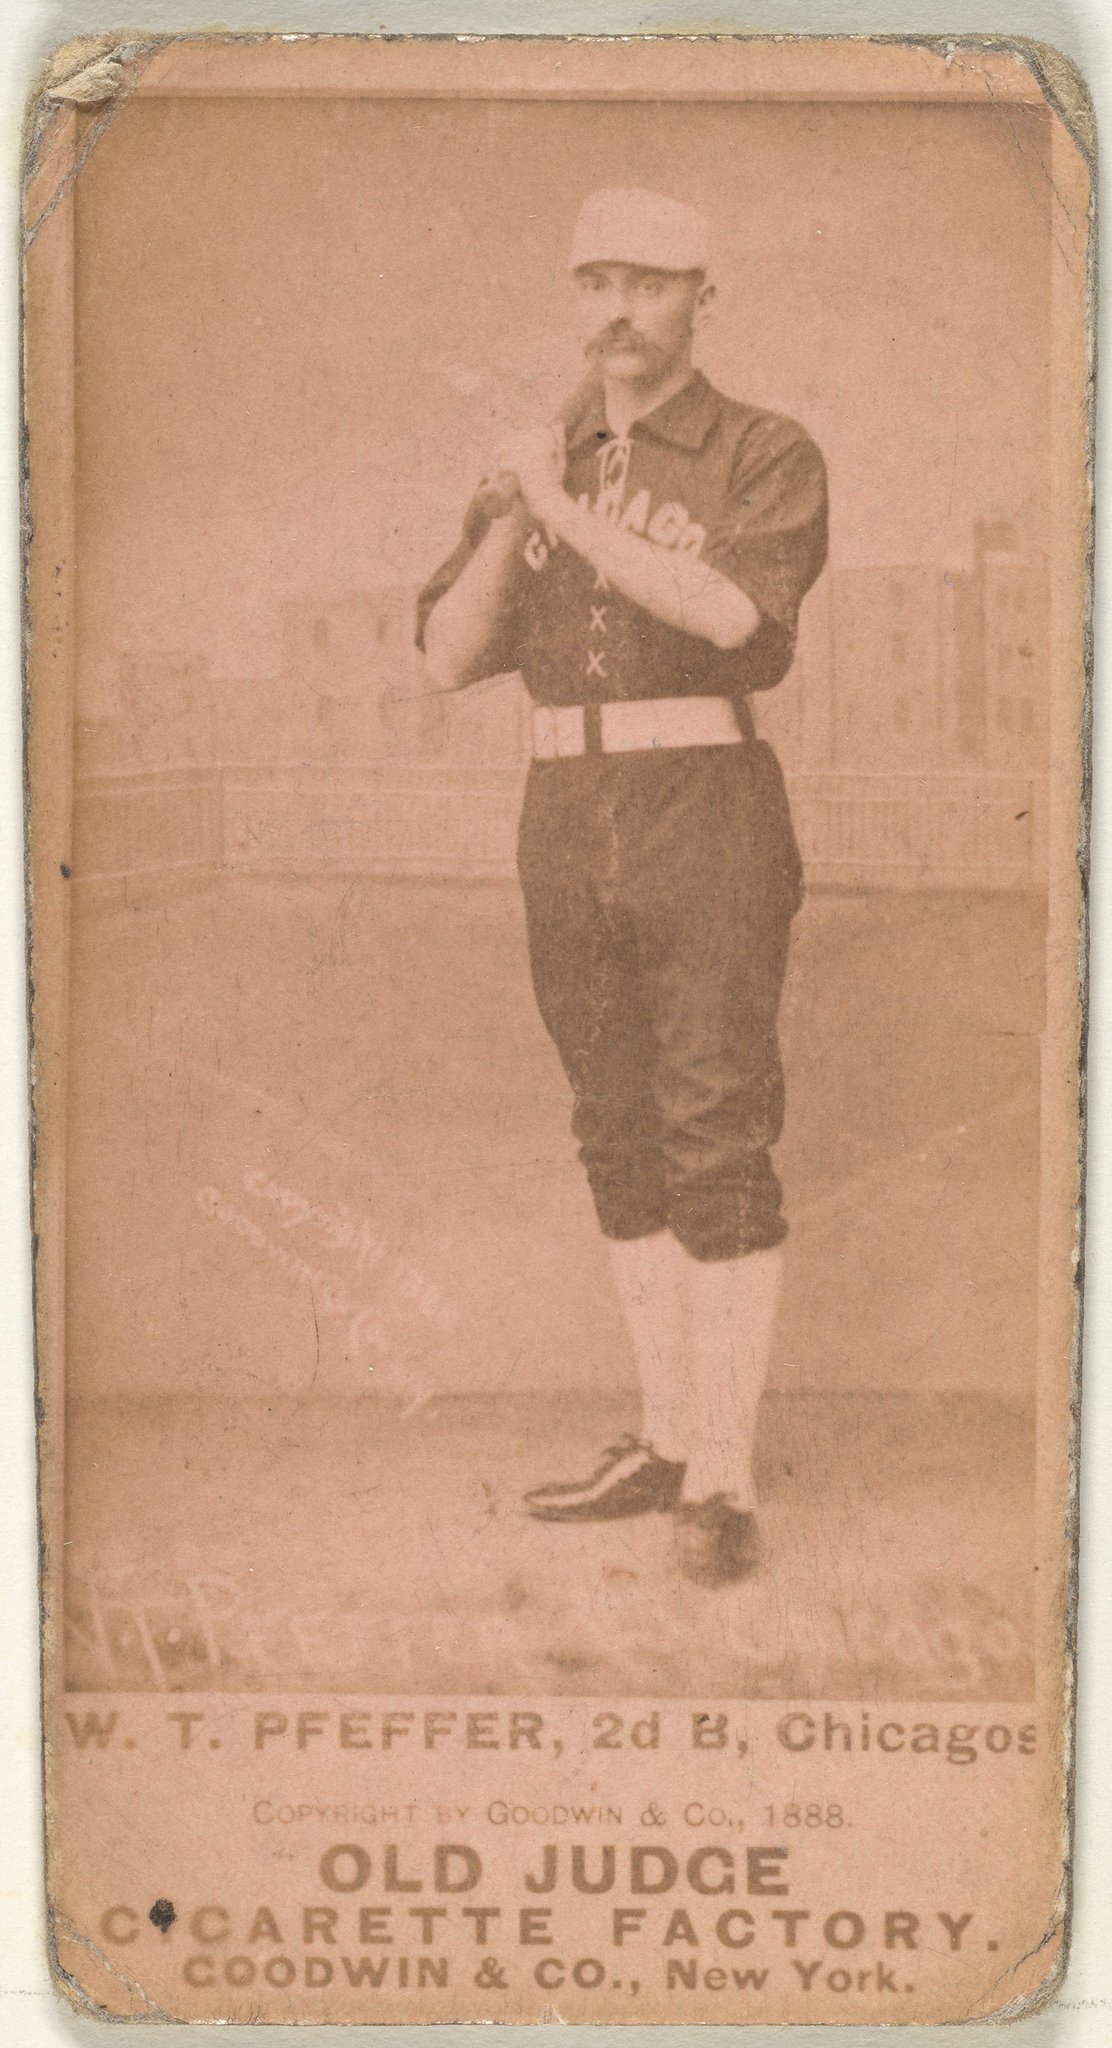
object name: baseball card, photograph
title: Fred "Dandelion" Pfeffer, 2nd Base, Chicago, from the Old Judge series (N172) for Old Judge Cigarettes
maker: goodwin & company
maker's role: publisher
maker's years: 1850-1950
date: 1888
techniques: albumen silver print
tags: men,portraits,baseball,athletes